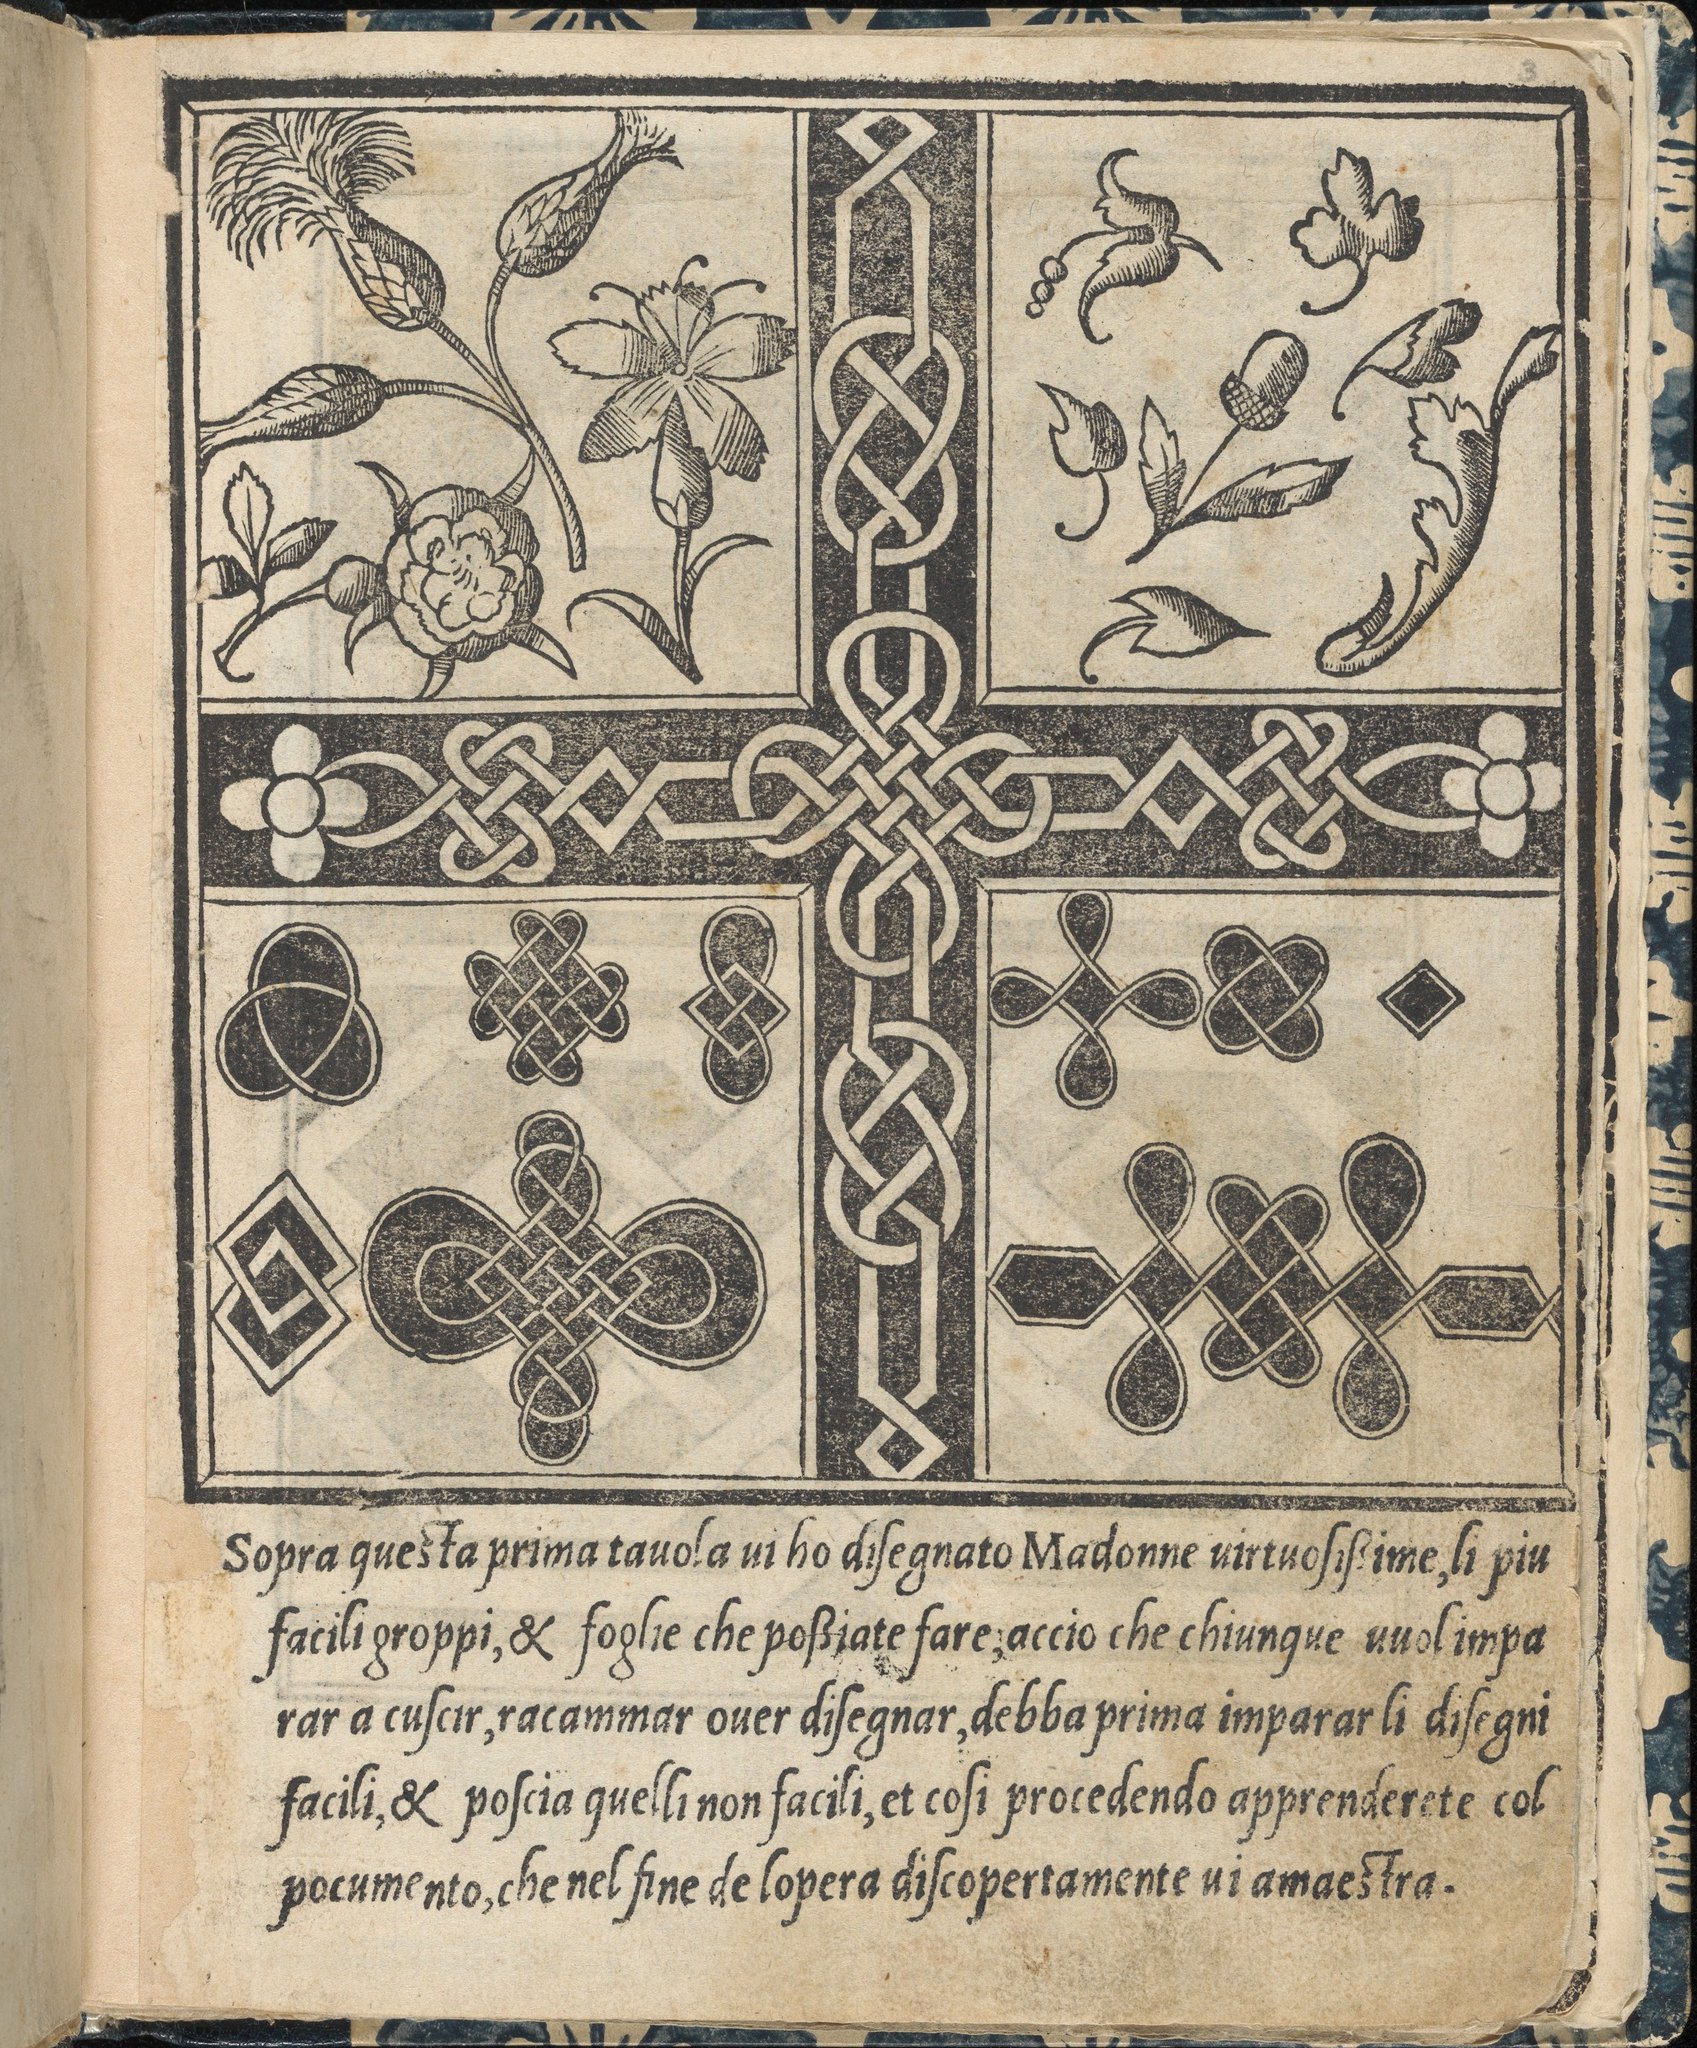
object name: book print ornament architecture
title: Essempio di recammi, page 3 (recto)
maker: giovanni antonio tagliente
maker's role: author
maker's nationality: italian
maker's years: 1465-1528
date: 1530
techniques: woodcut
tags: ornament